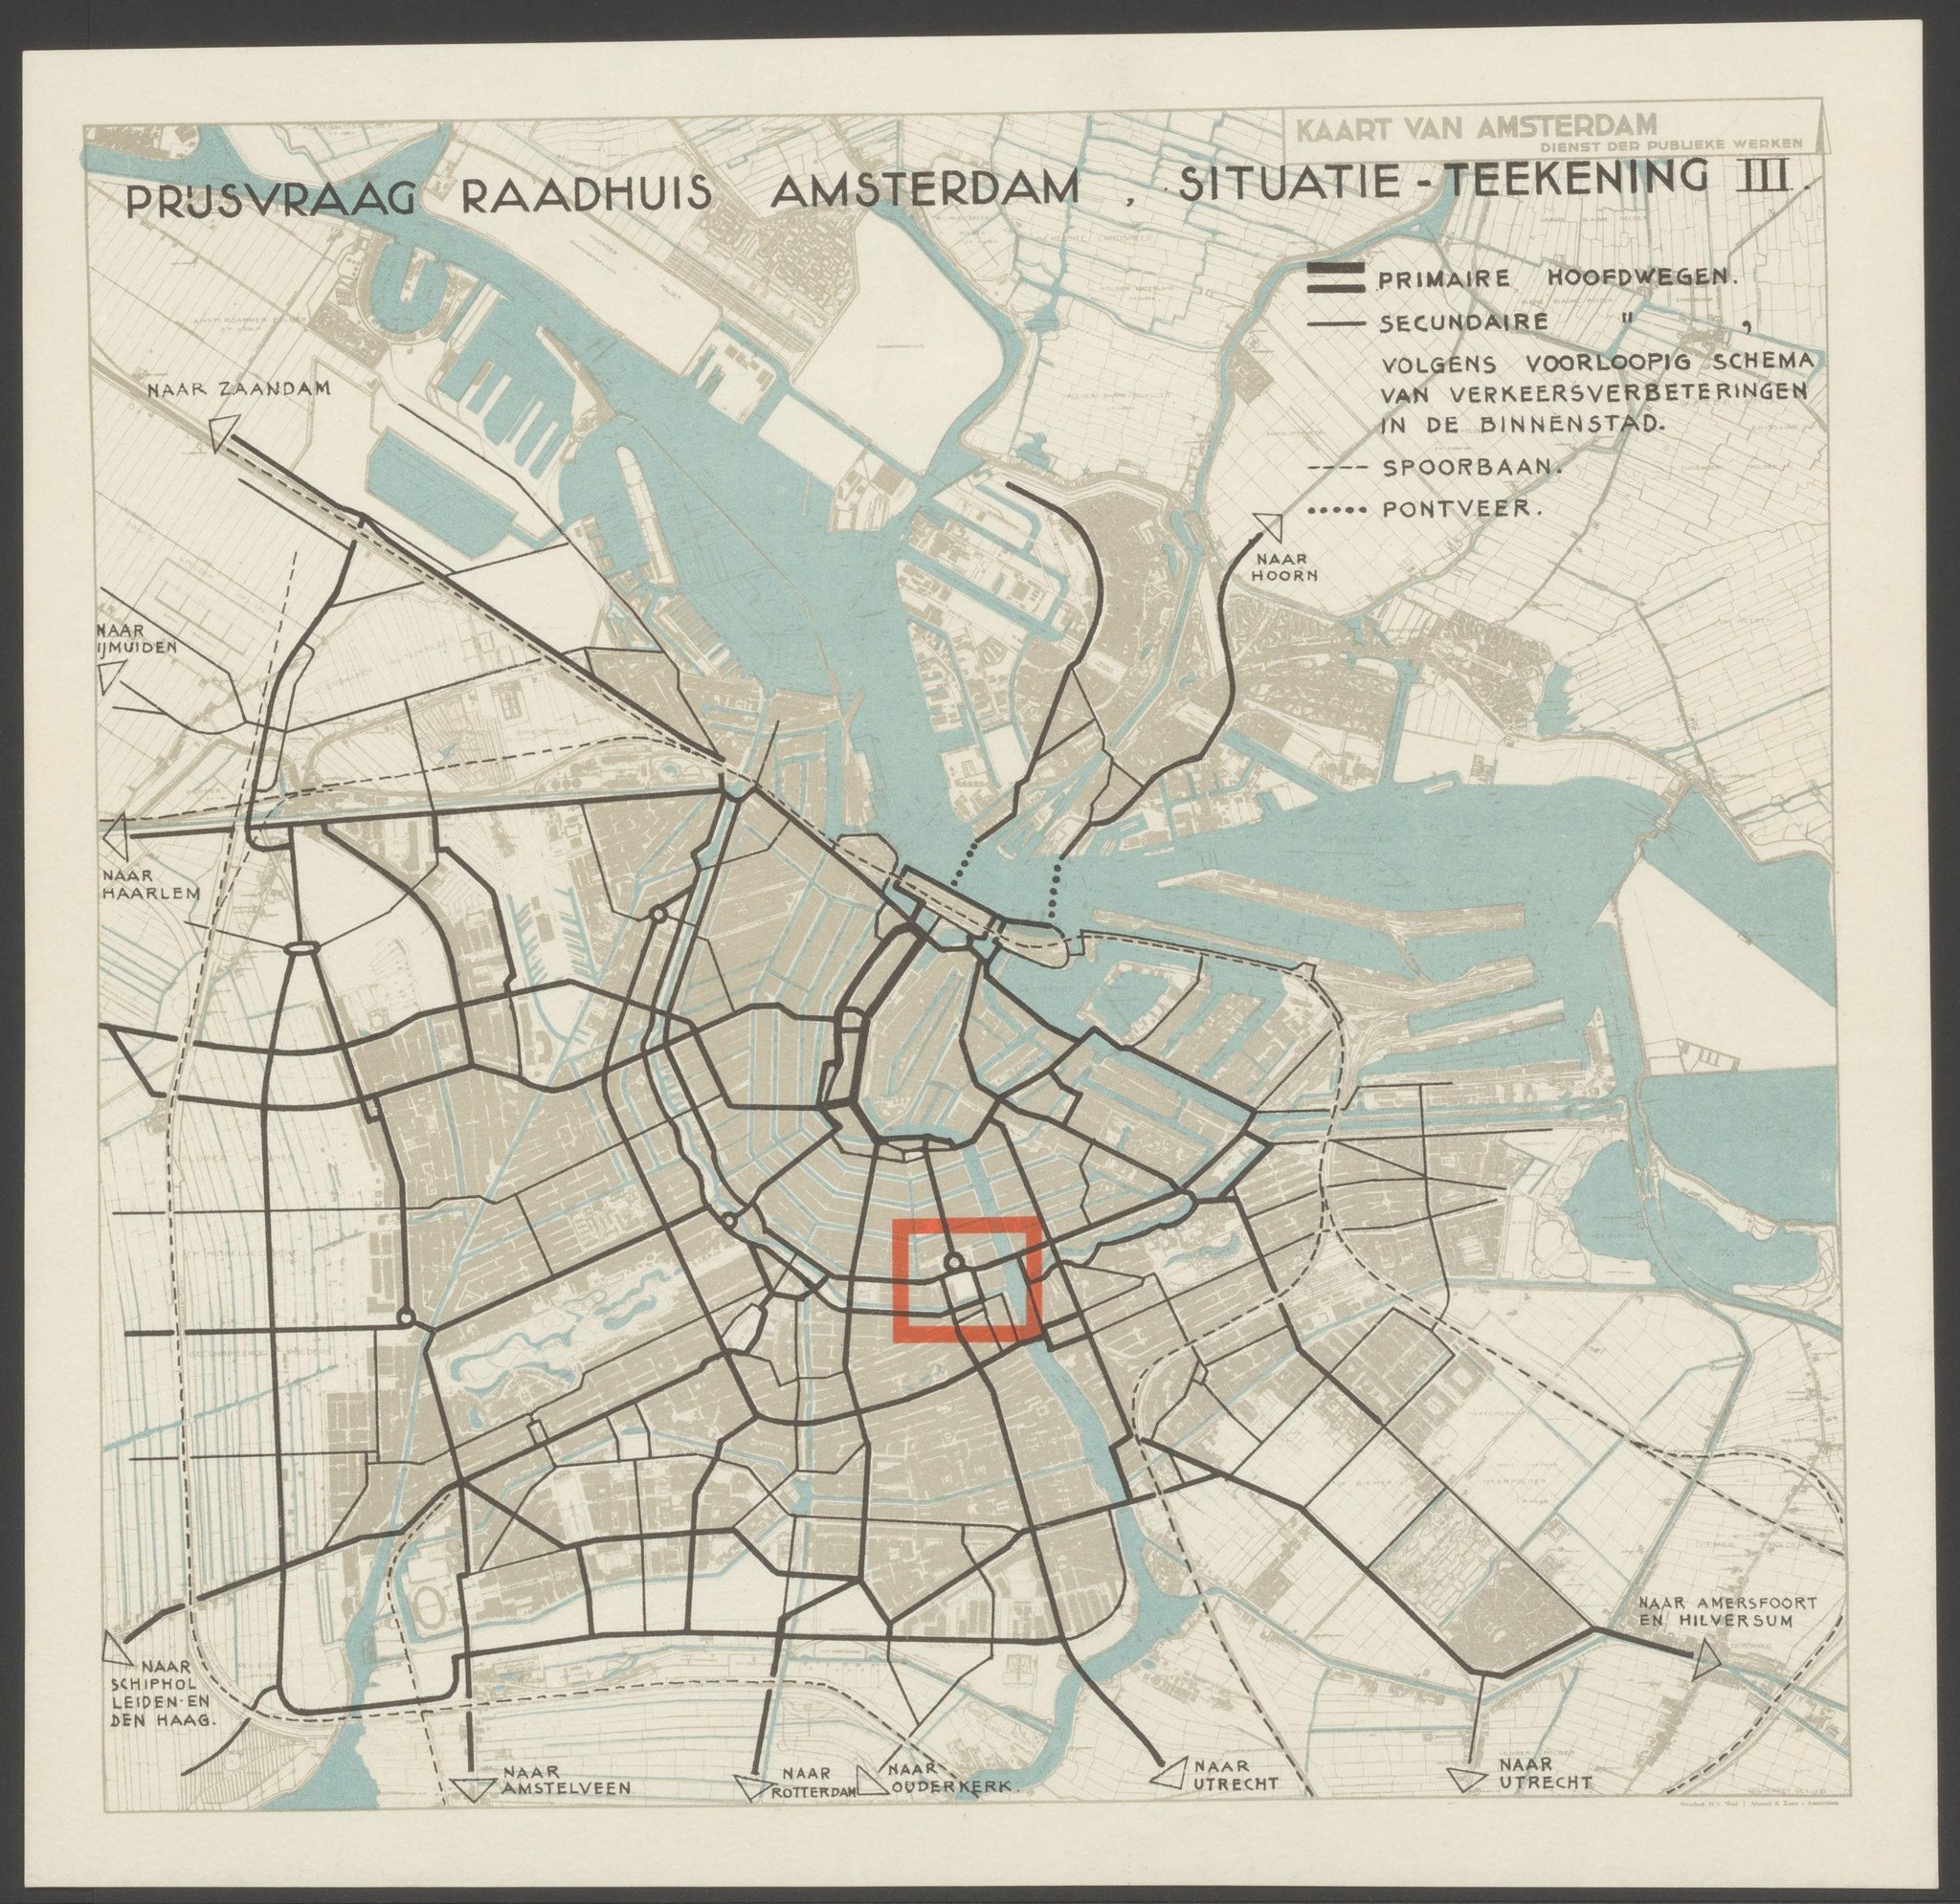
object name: area plan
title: Plattegrond van Amsterdam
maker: Anonymous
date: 1935-1937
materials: paper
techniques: lithograph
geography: amsterdam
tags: city-view in general; 'veduta', maps of cities, amsterdam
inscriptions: collector's mark: ‘17 68’ Lugt 1641b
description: Onderwerpsrubriek binnen de Atlas Amsterdam: Nieuwe Stadhuis, van binnen: Stadhuis Frederiksplein. Prijsvraag voor een nieuw te bouwen stadhuis op de plek van het afgebrande Paleis voor Volksvlijt bij het Frederiksplein, maar nooit gerealiseerd.